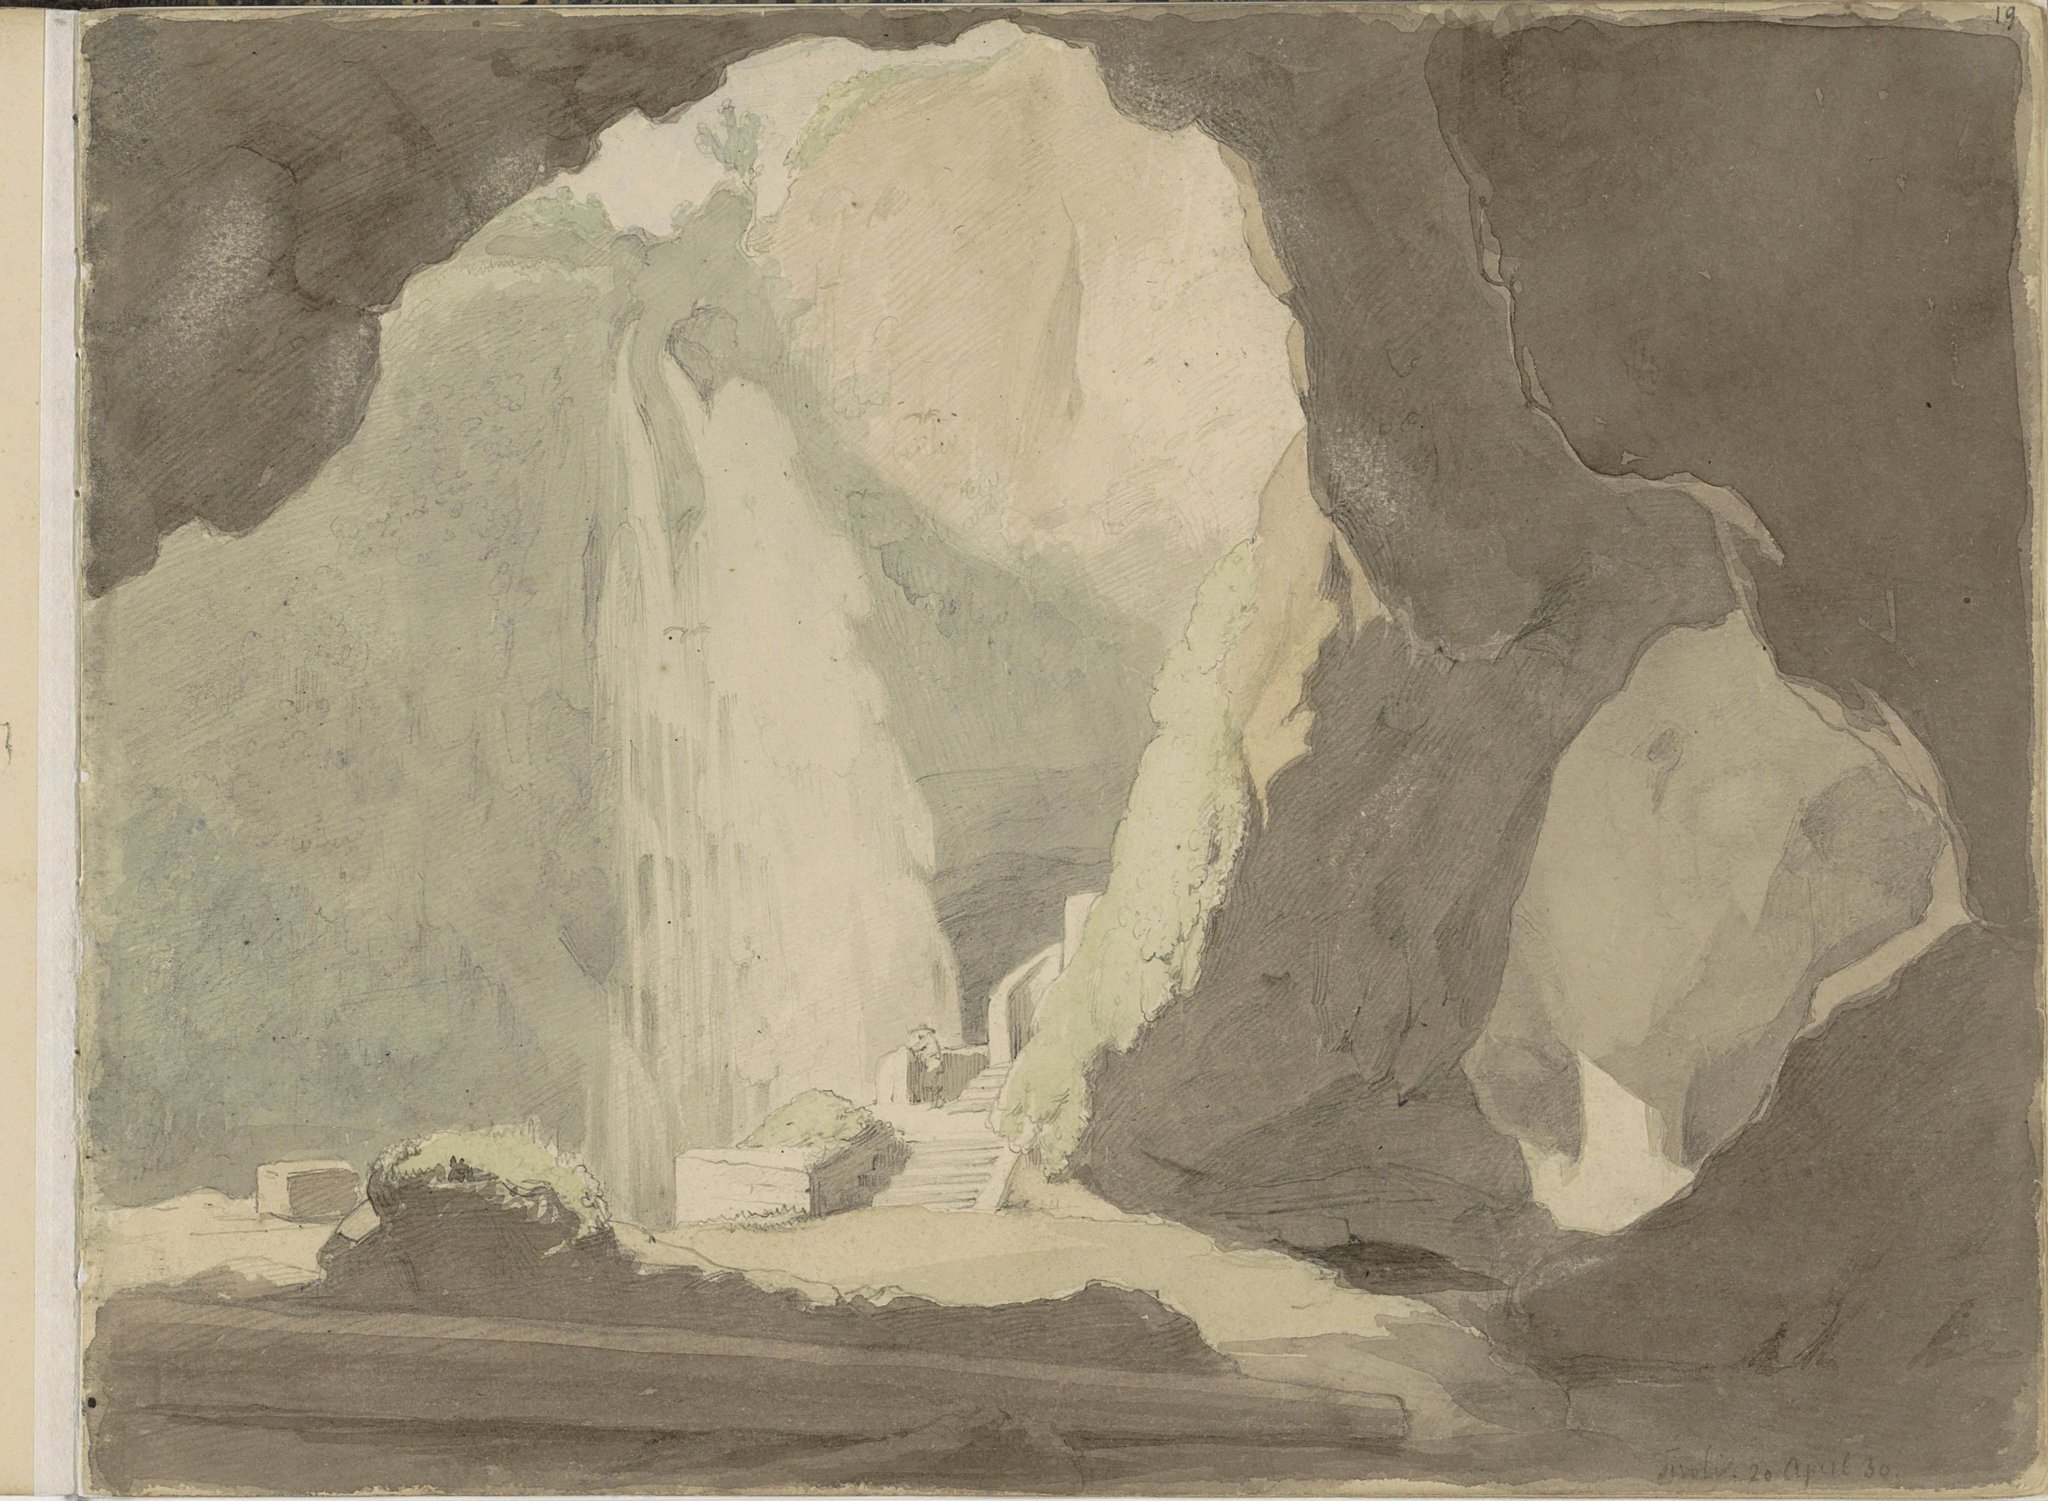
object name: sketchbook leaf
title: Waterval in Tivoli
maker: jacobus everhardus josephus van den berg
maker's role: draughtsman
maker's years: 1802-1861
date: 1804-1830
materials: paper, pencil, watercolor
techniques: brush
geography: tivoli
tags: waterfall, tivoli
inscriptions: date and inscription: ‘Tivoli 20 april 30.’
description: Blad 19 recto uit een schetsboek met 26 bladen.